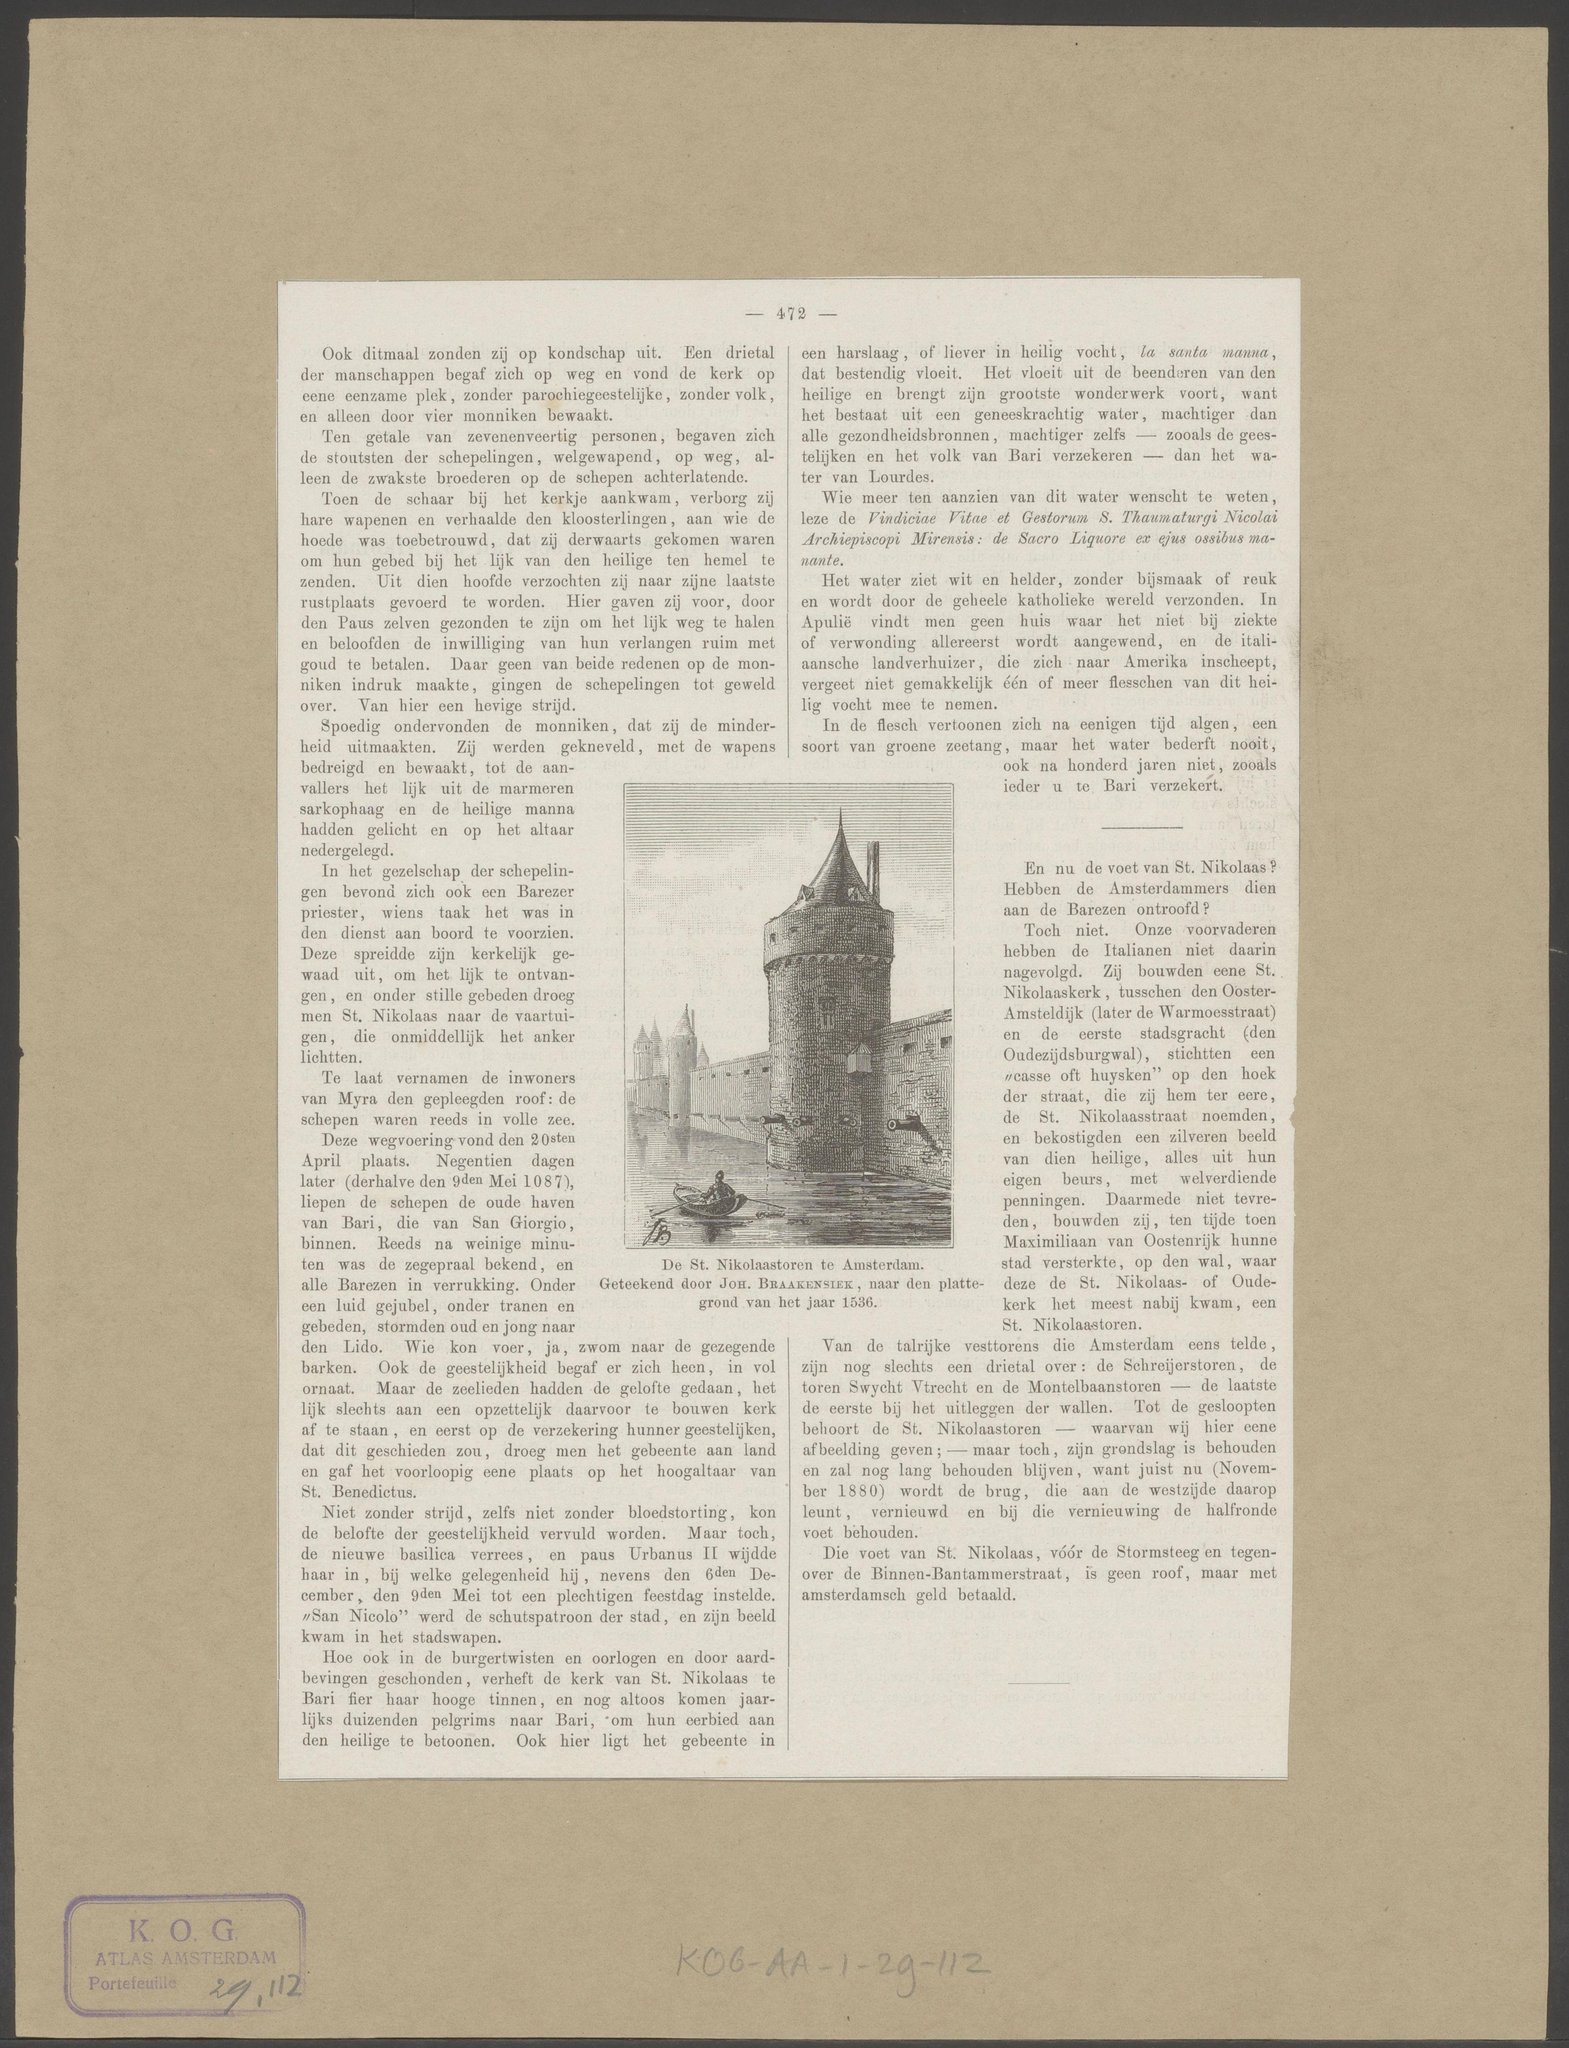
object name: photomechanical print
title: De St. Nikolaastoren te Amsterdam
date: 1880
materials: paper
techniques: letterpress printing, line block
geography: haarlem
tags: moat ~ fortified city, towers ~ fortified city, rowing-boat, canoe, etc., amsterdam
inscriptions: collector's mark: Lugt 1641b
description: Prent uit: Eigen Haard 6 (1880), nr. 49, 4 december 1880, p. 472.